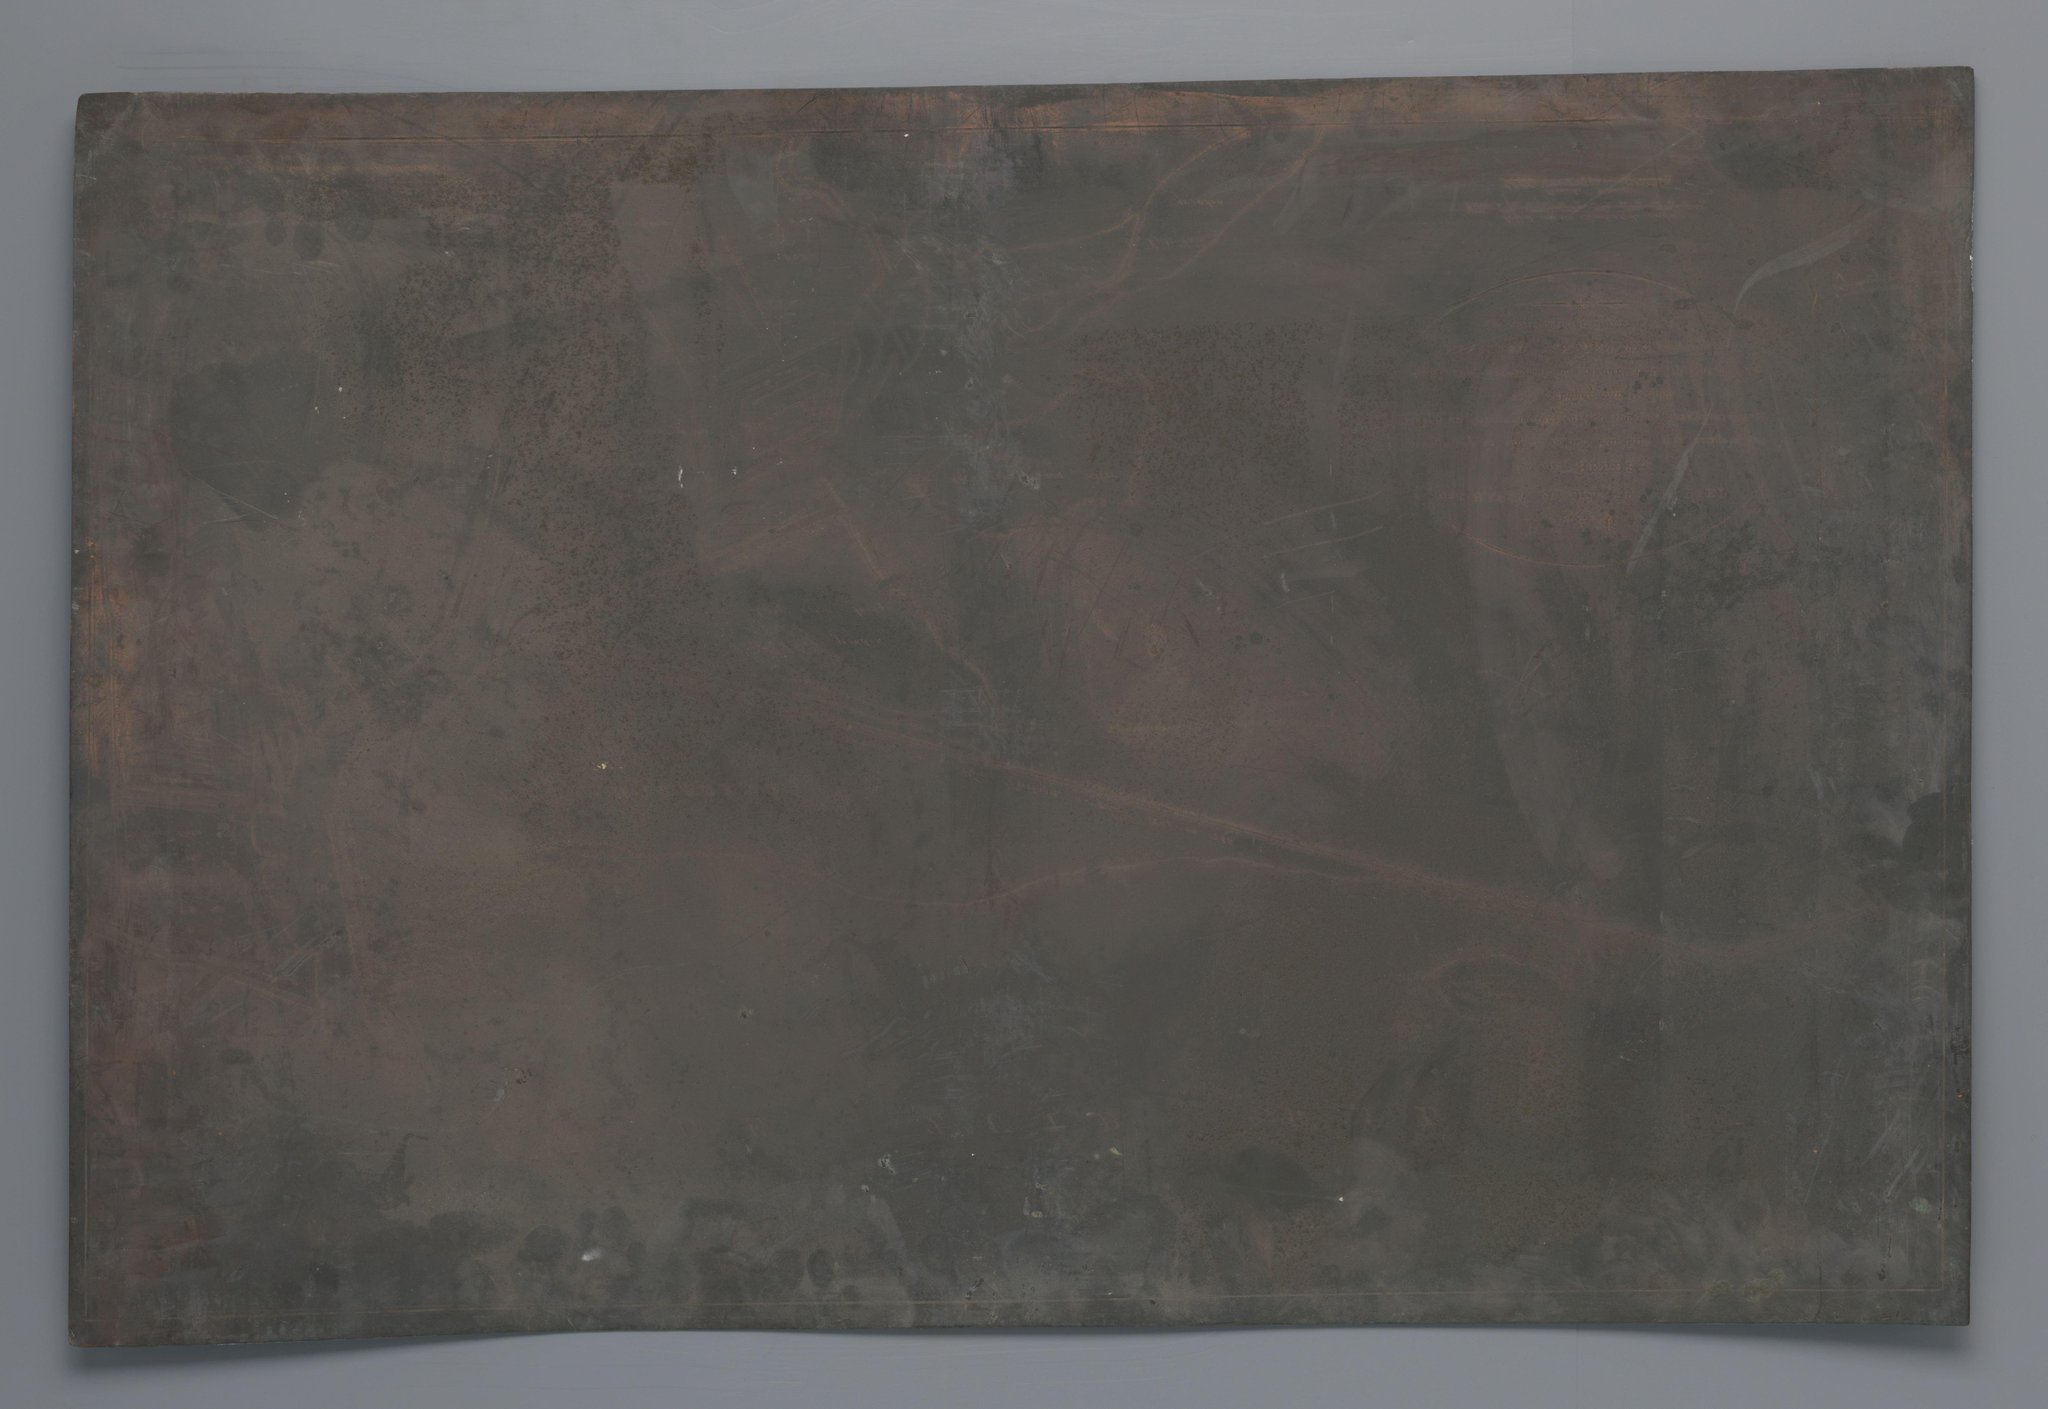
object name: copper plate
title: Kaart van het Nieuwe Diep aan de Helder (...)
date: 1787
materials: copper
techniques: engraving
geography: the hague